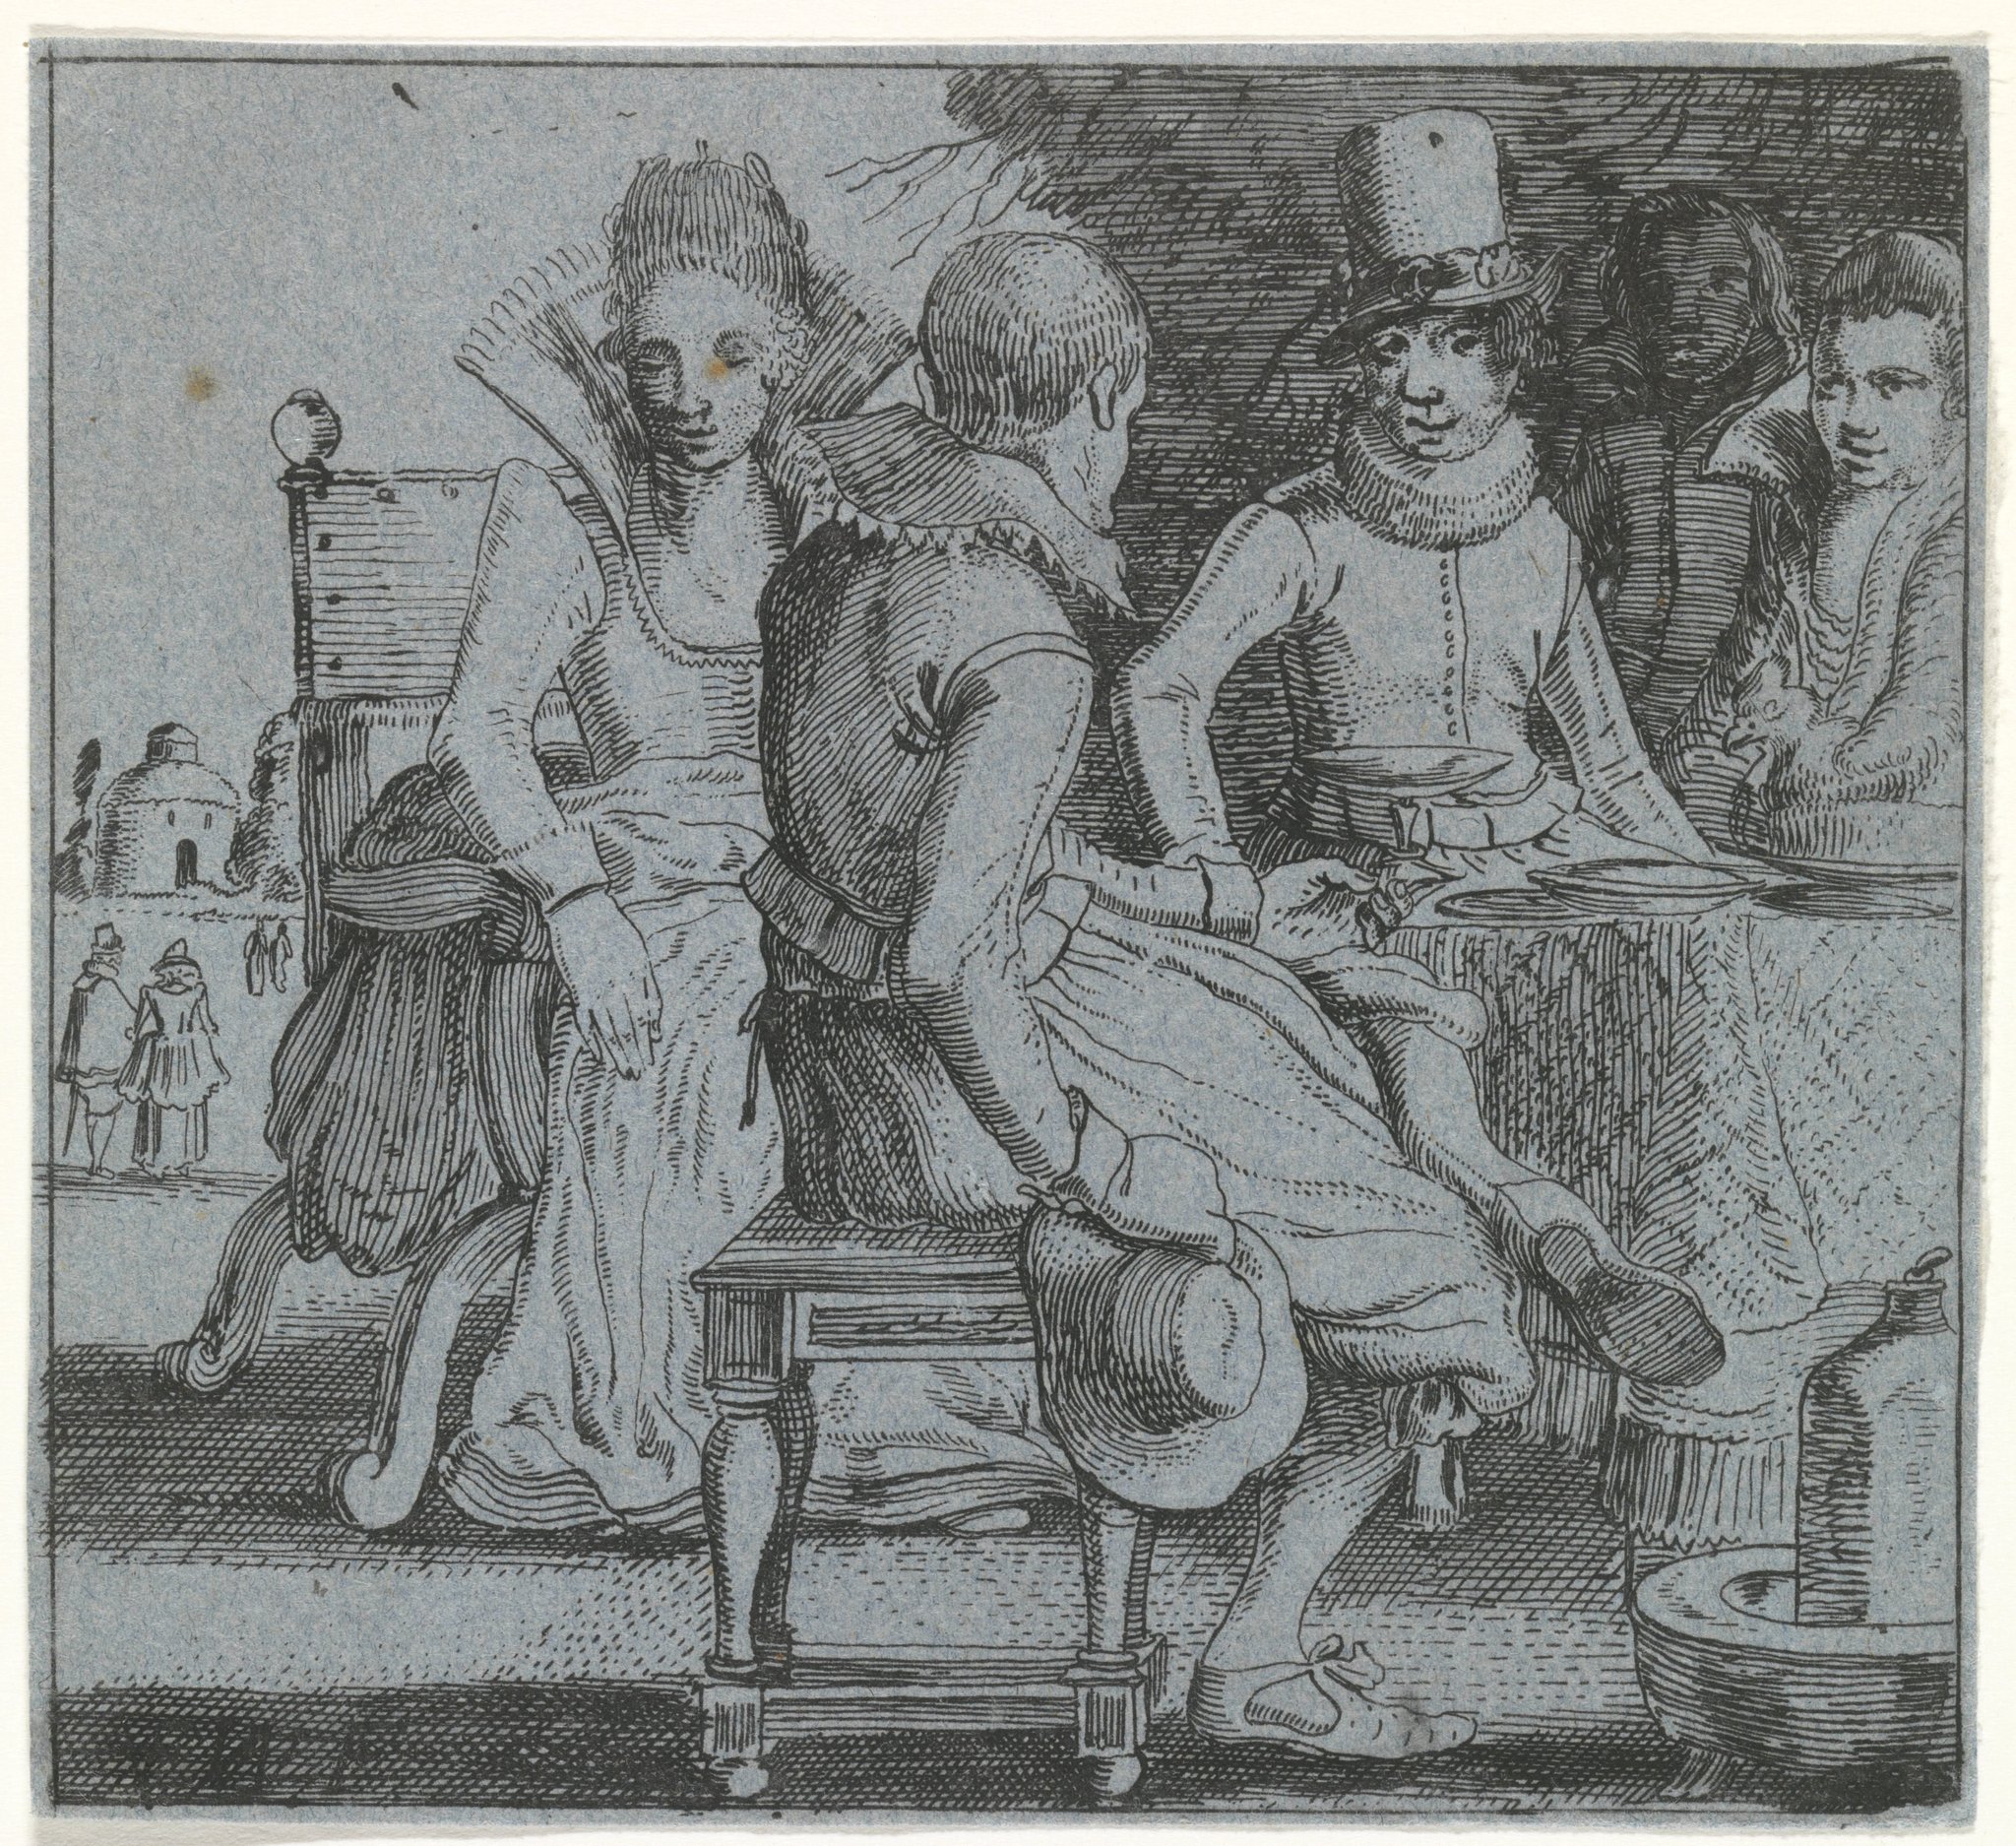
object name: print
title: Vijf personen zittend rond een tafel op een terras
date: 1615-1680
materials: paper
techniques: etching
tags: visiting; receiving guests; elegant company, dress, gown (+ women's clothes)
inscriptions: collector's mark: Lugt 2228, collector's mark: Lugt 2610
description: Vijf modieus geklede dames en heren zitten en staan bij een gedekte tafel op een terras.